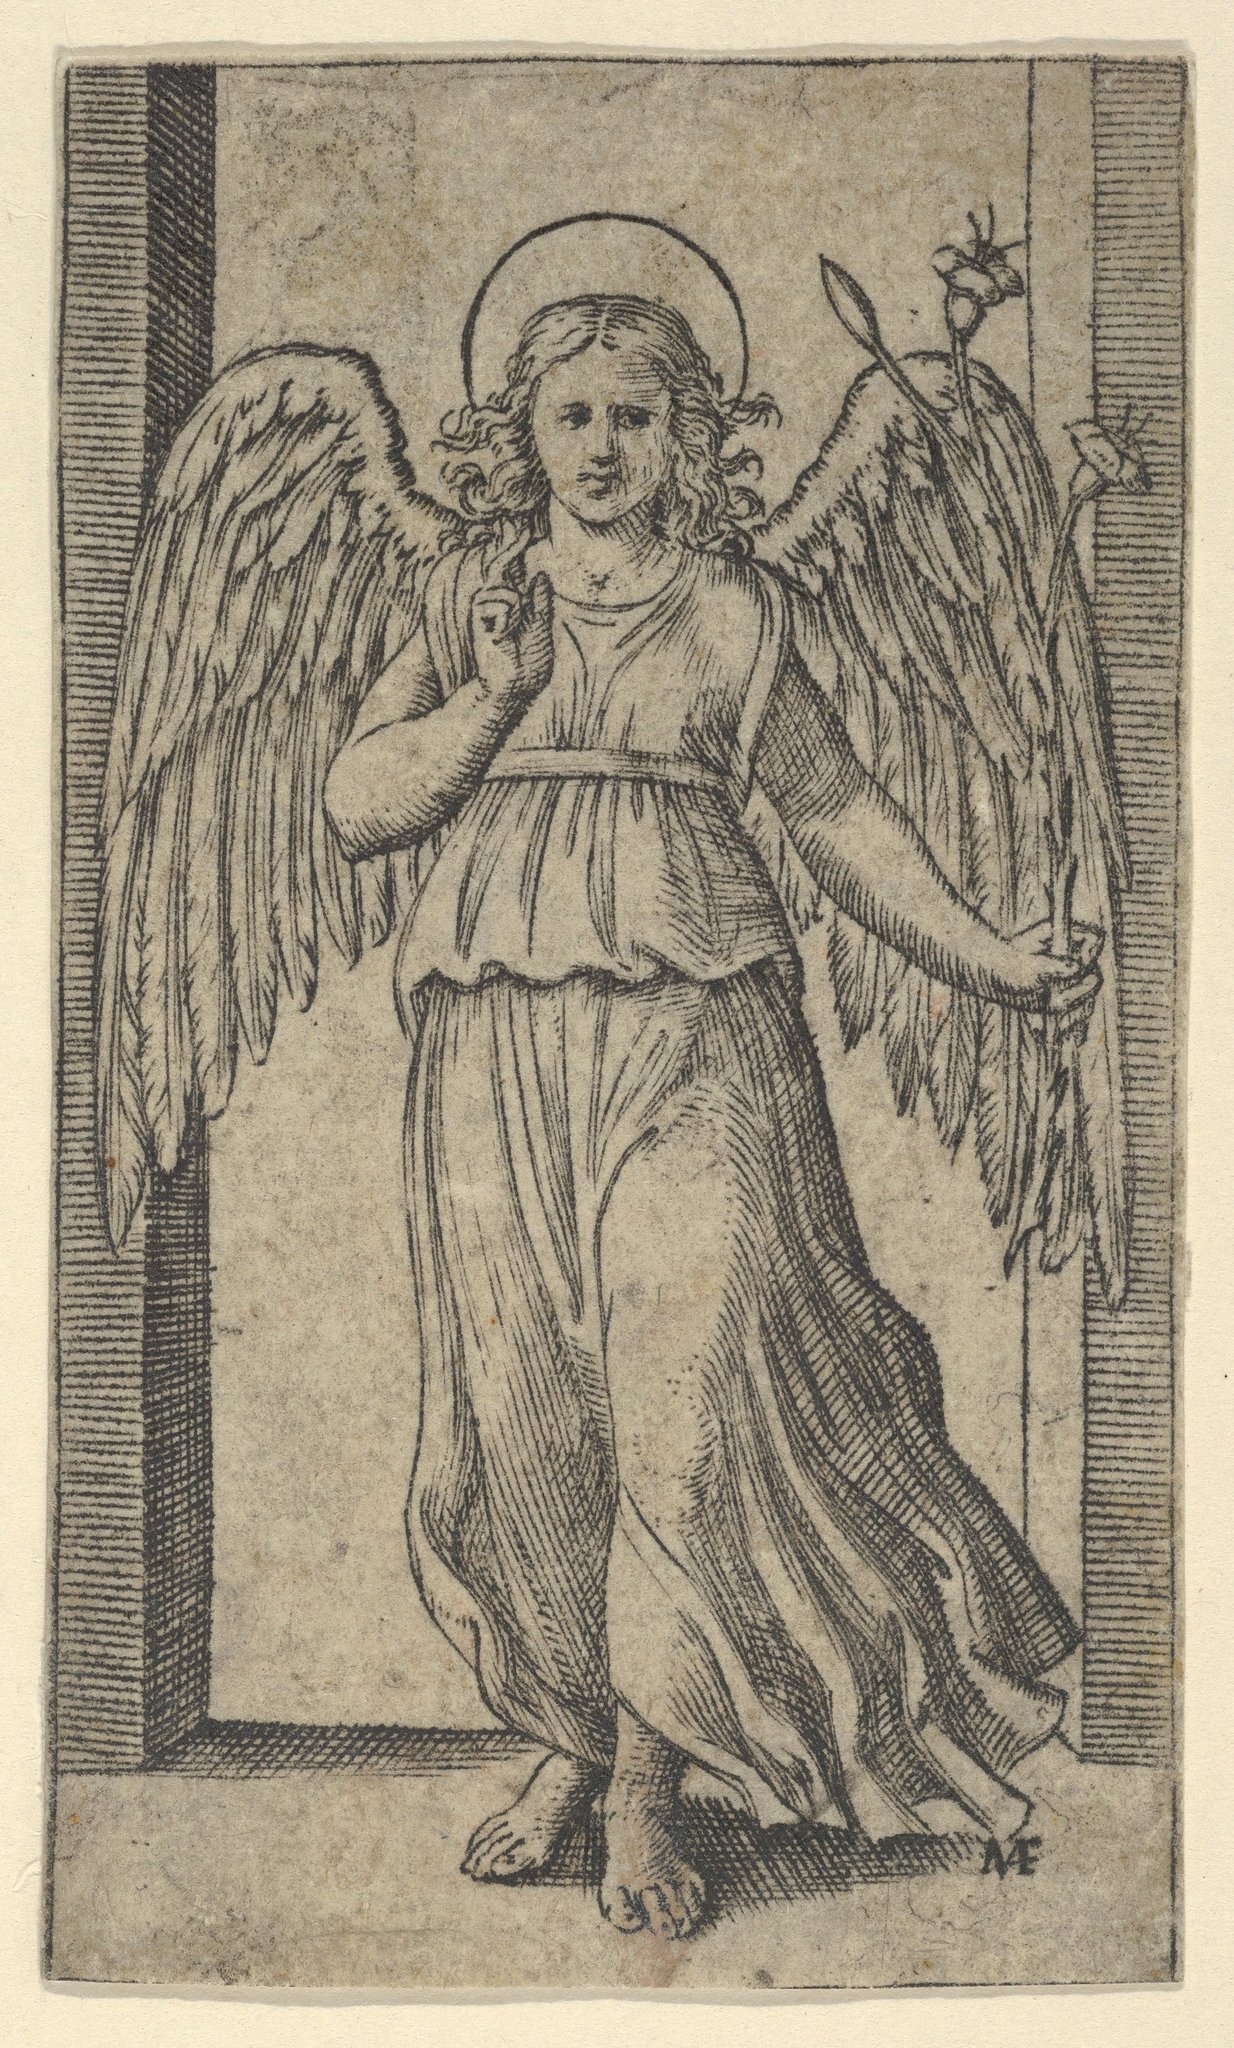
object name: print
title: The Angel Gabriel standing, from "Piccoli Santi" (Small Saints)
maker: marcantonio raimondi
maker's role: artist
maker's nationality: italian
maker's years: 1475-1534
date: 1500-1527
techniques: engraving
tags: archangel gabriel